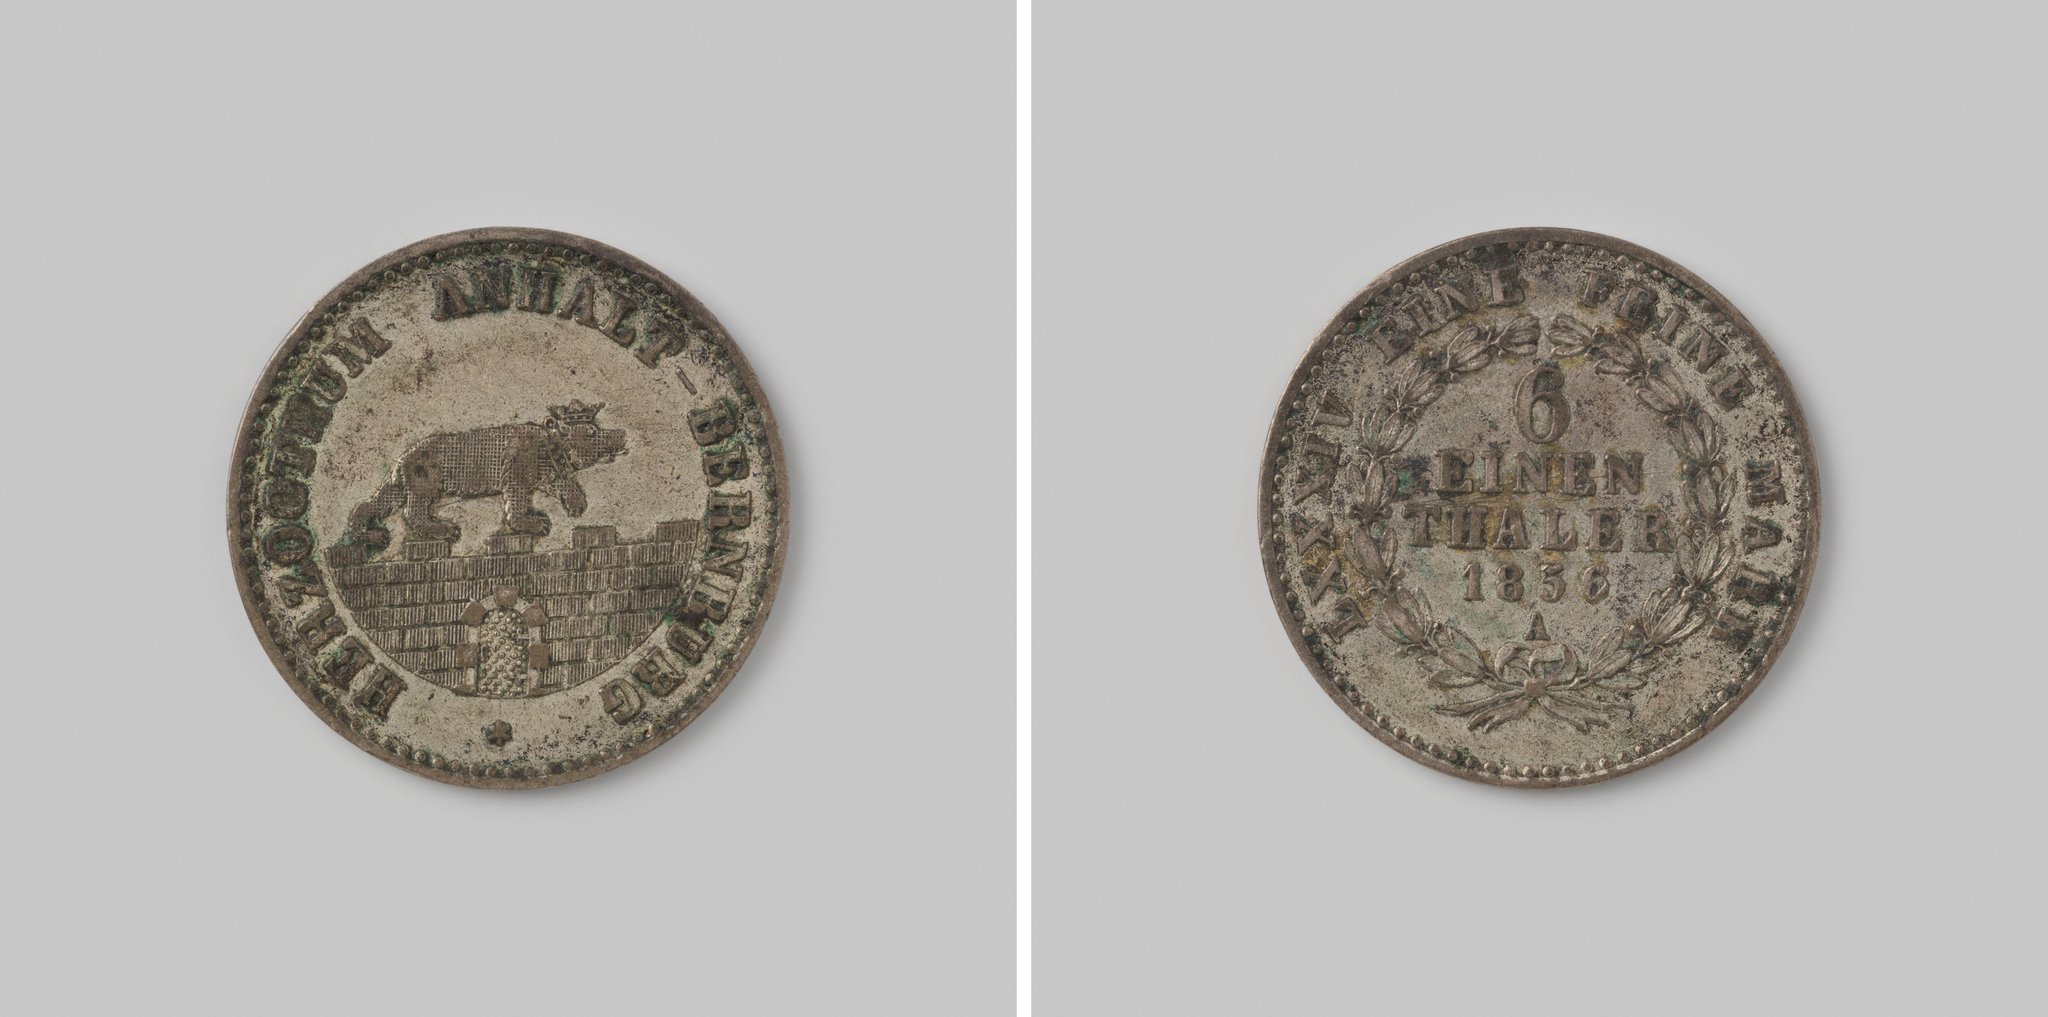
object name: zesde taler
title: Hertogdom Anhalt-Bernburg, Alexander Karl, 1/6 taler, 1856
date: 1856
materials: silver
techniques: striking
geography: berlin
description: Zilveren munt. Voorzijde: gekroonde beer met halsband, naar rechts lopend op stadsmuur met poort. Keerzijde: binnen twee samengebonden takken waarde-aanduiding in drie regels, waaronder jaartal. Daaronder letter A. Randschrift.